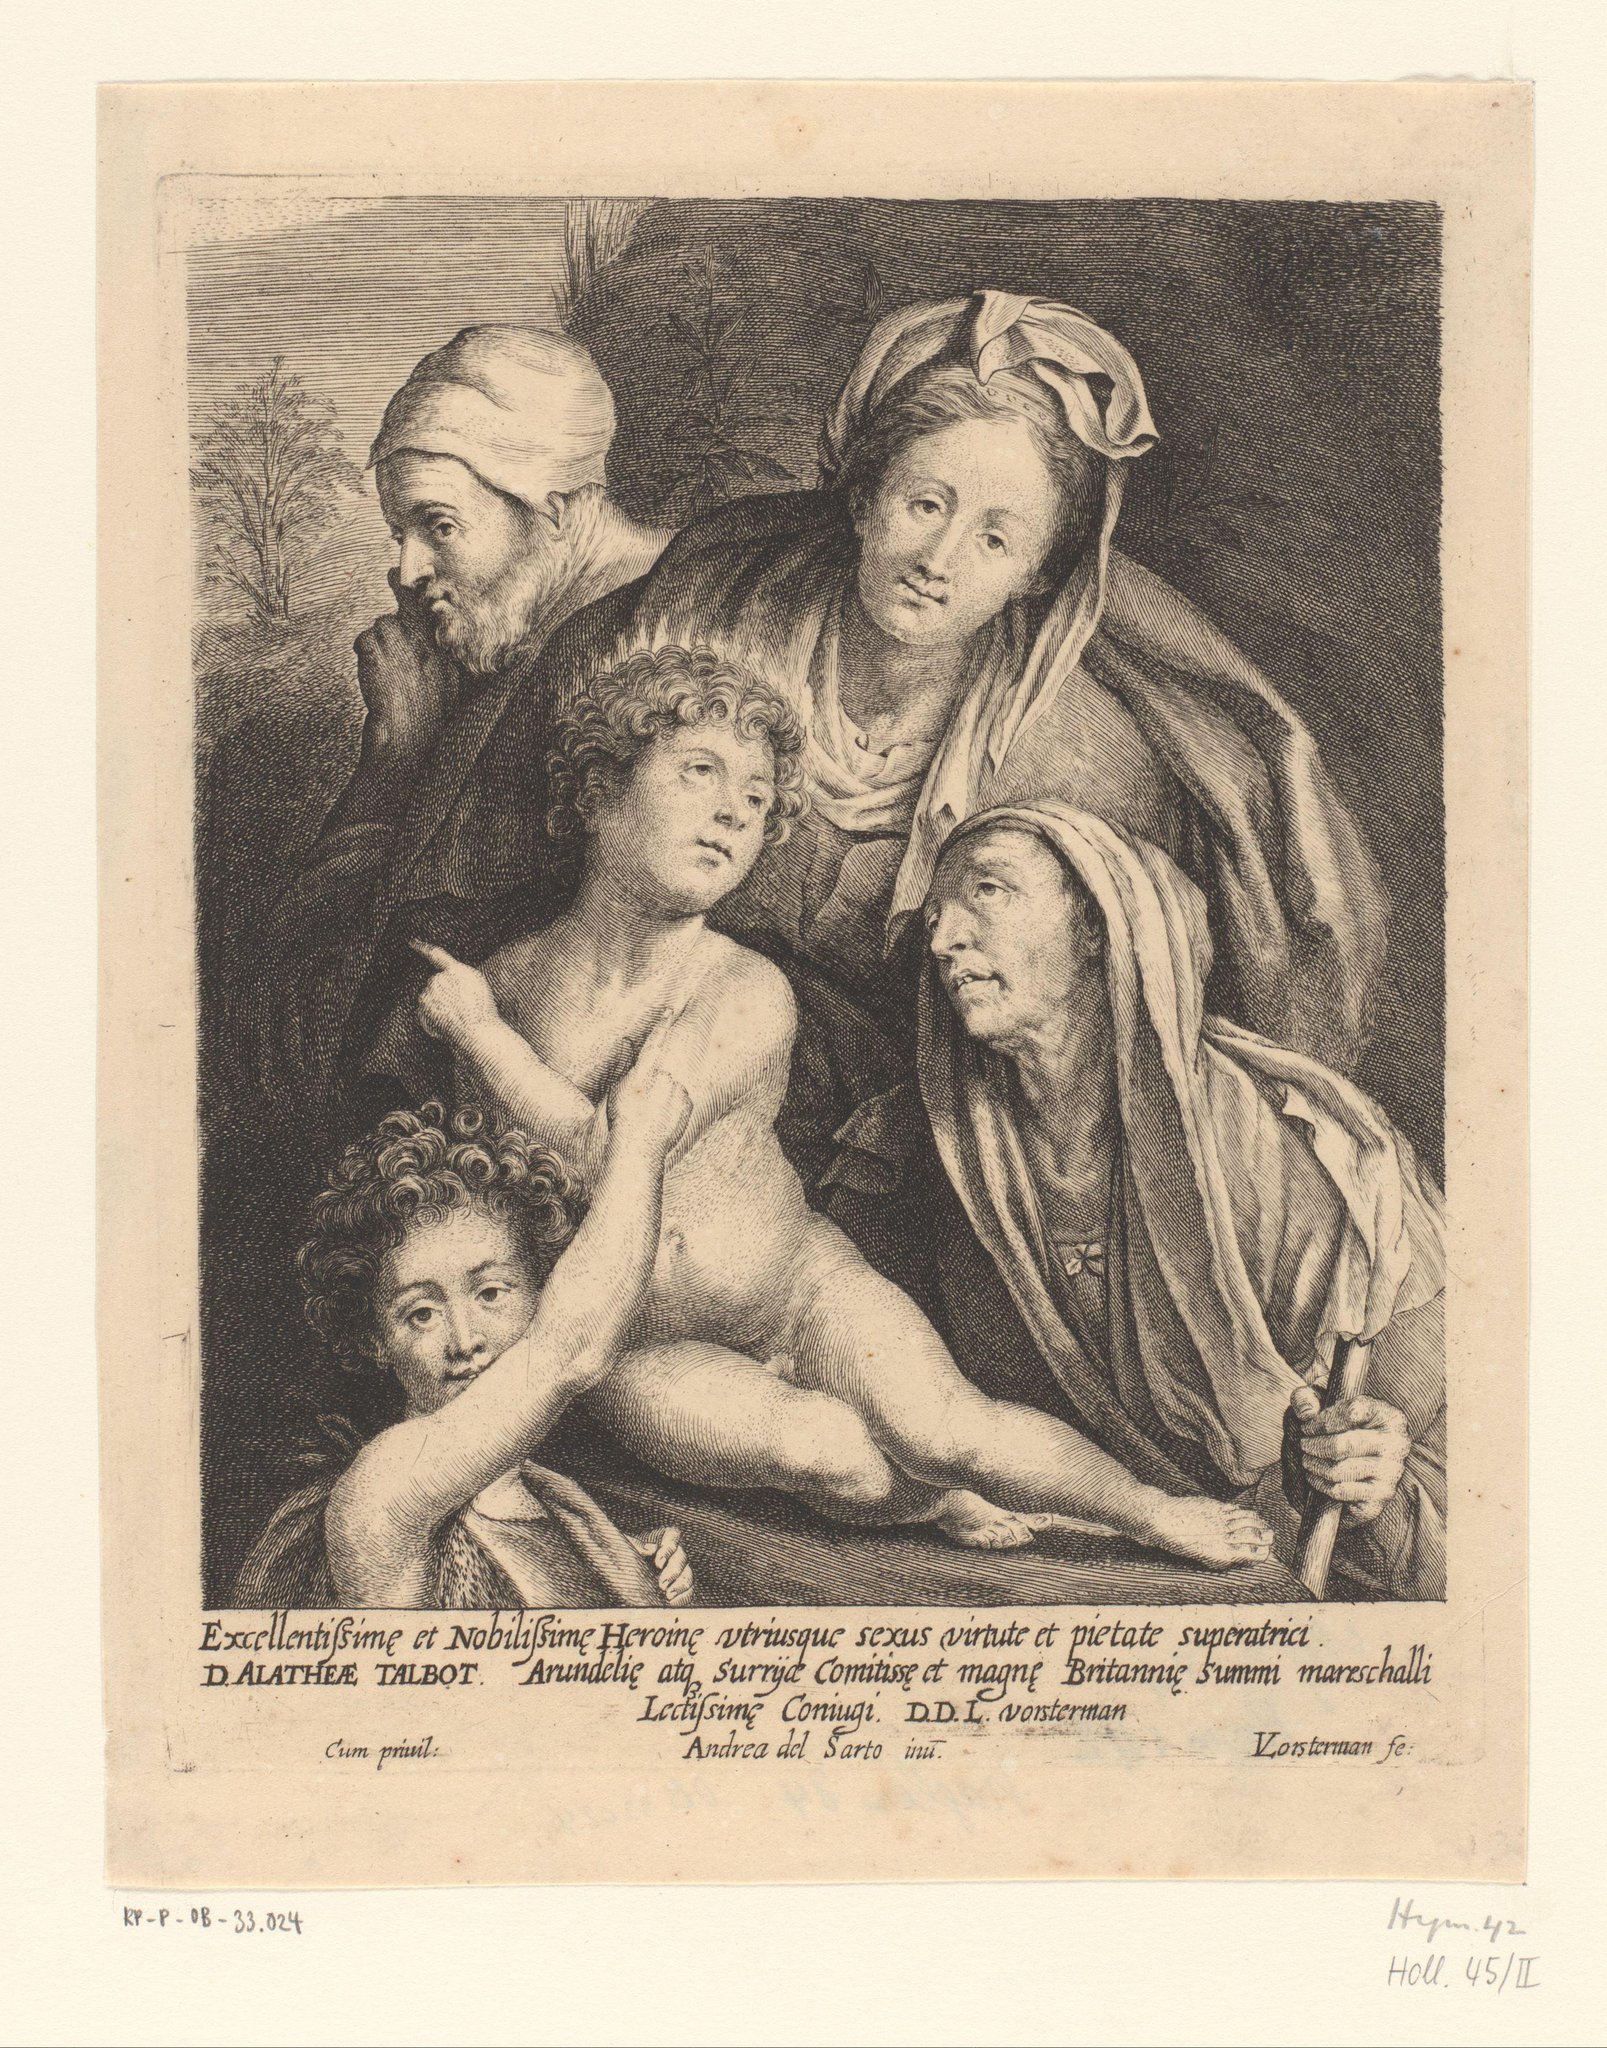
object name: print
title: Heilige Familie met Elisabet en Johannes de Doper als kind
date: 1619-1675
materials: paper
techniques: engraving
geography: antwerp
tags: holy family with john the baptist, elisabeth present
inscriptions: collector's mark: Lugt 240